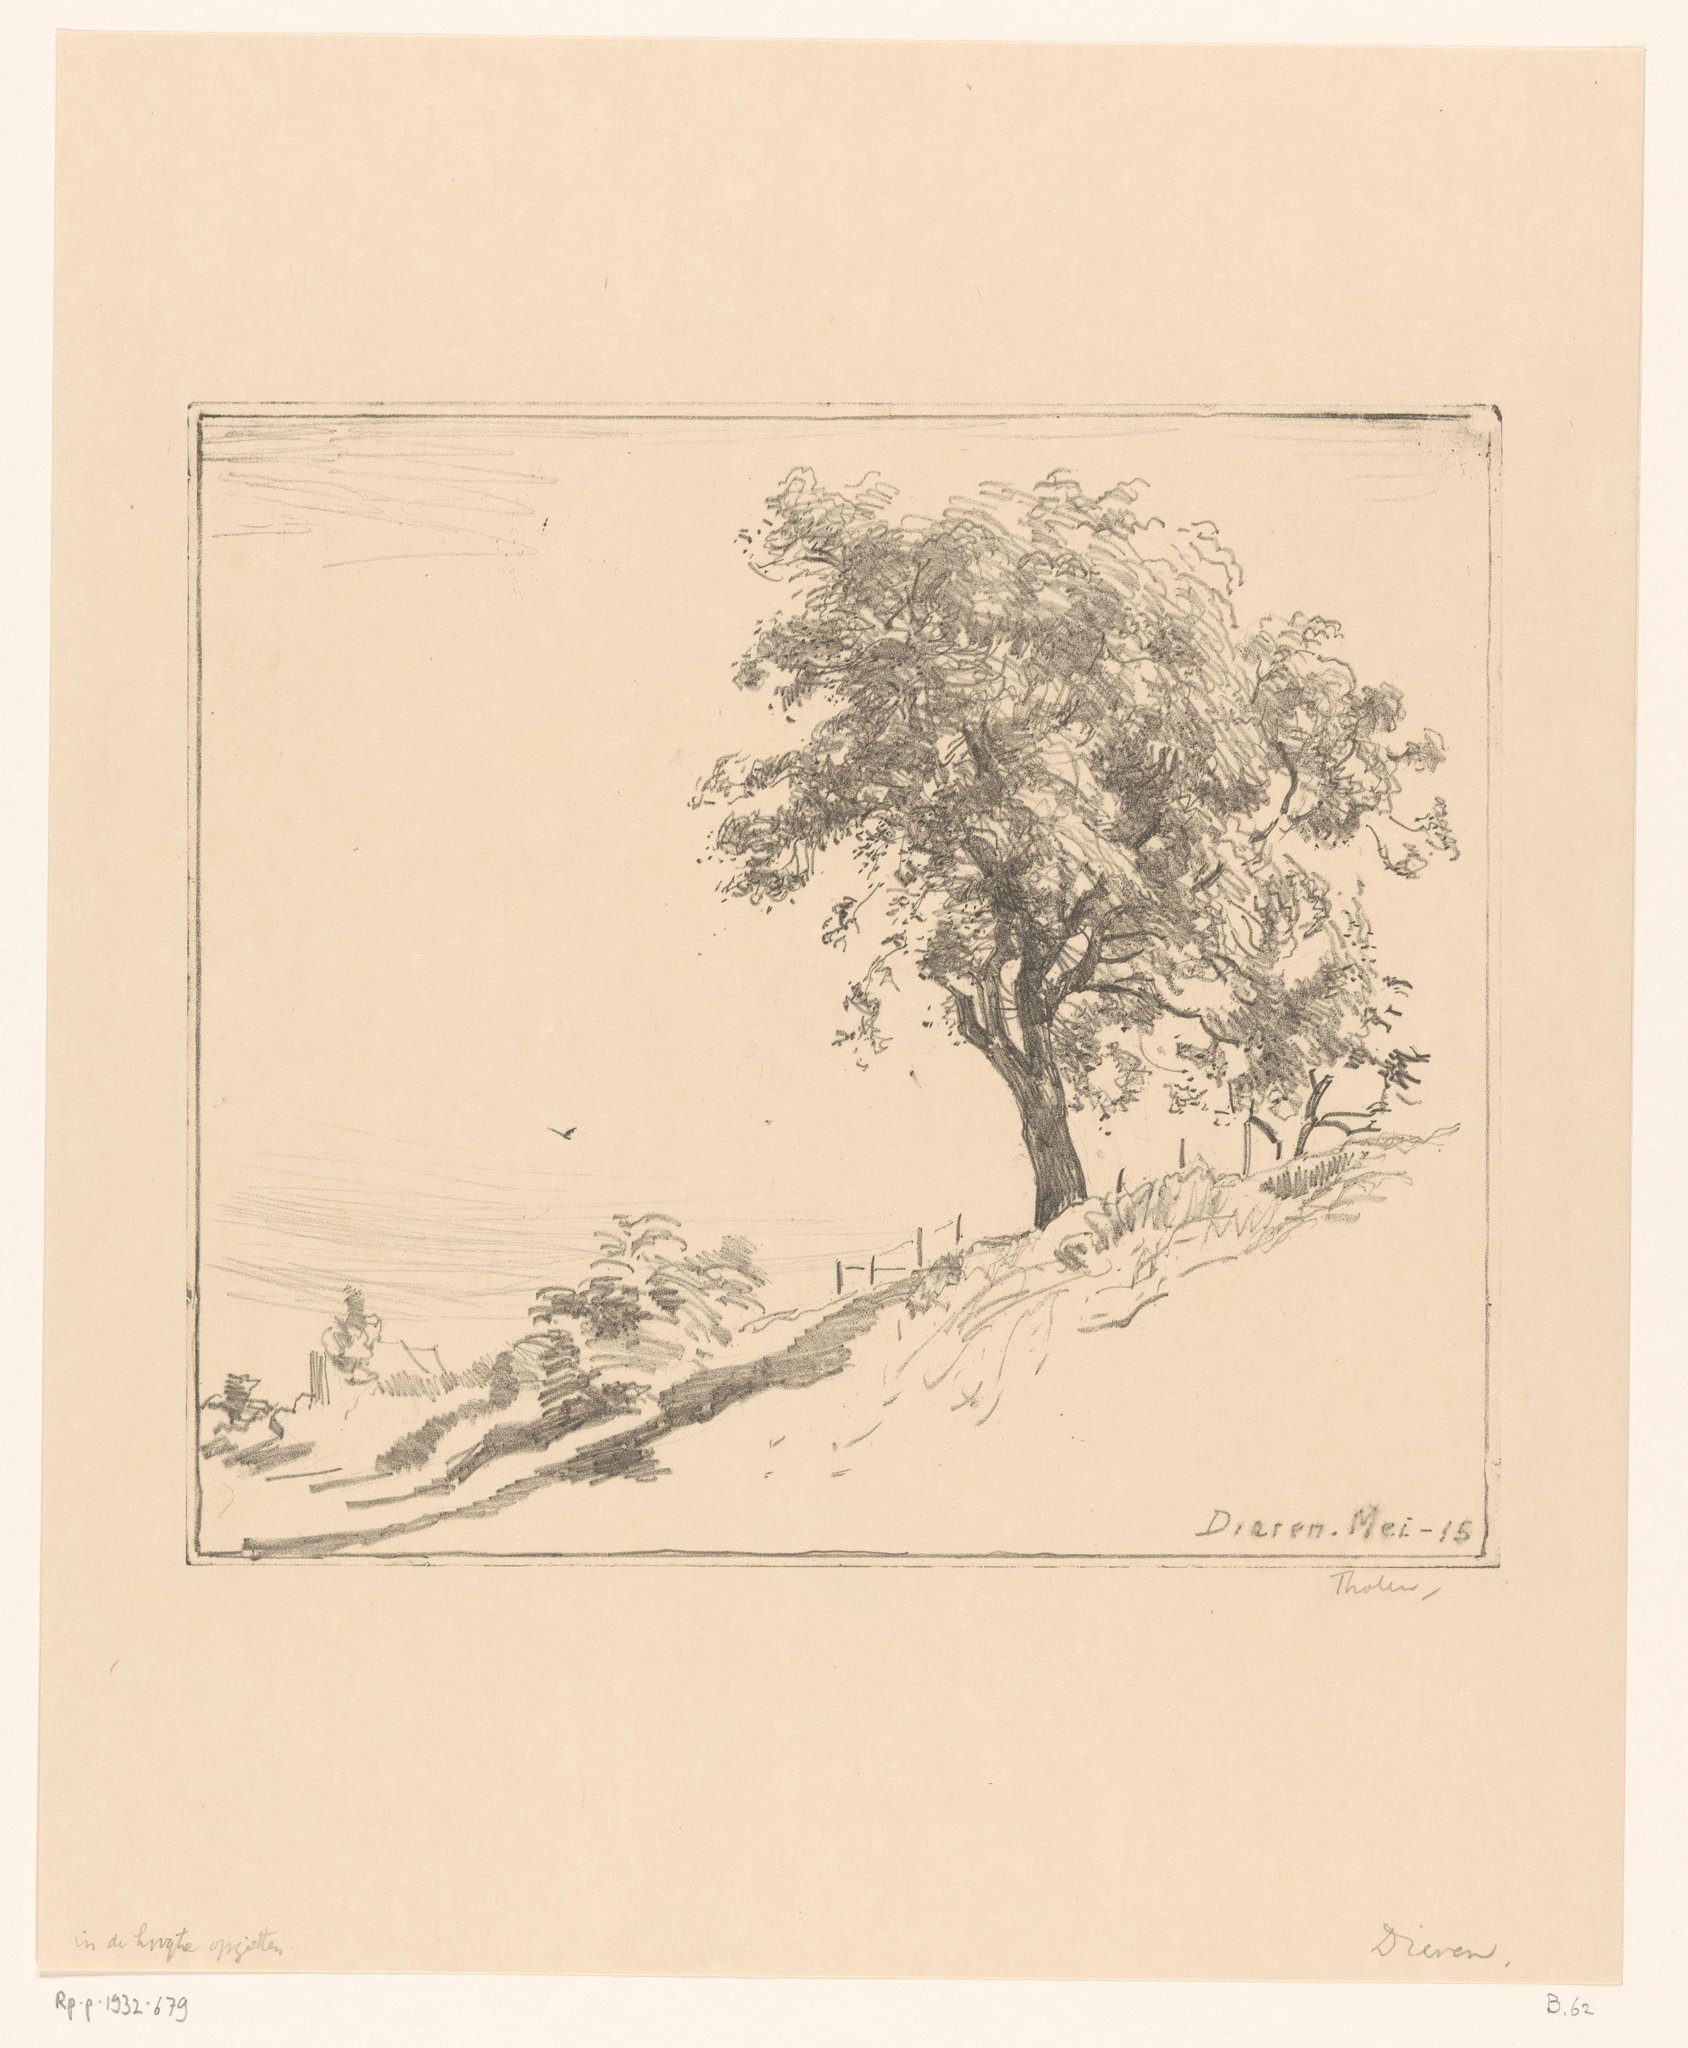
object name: print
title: Boom op dijk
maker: willem bastiaan tholen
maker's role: draughtsman, painter, print maker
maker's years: 1860-1931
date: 1905-1920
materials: paper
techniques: lithograph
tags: trees, dikes, levee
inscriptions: annotation: ‘Dieren-Mei-15’, collector's mark: Lugt 2228